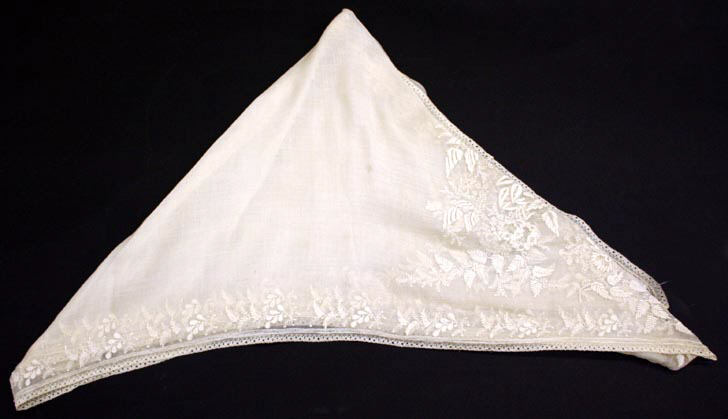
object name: kerchief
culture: french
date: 1830-1839